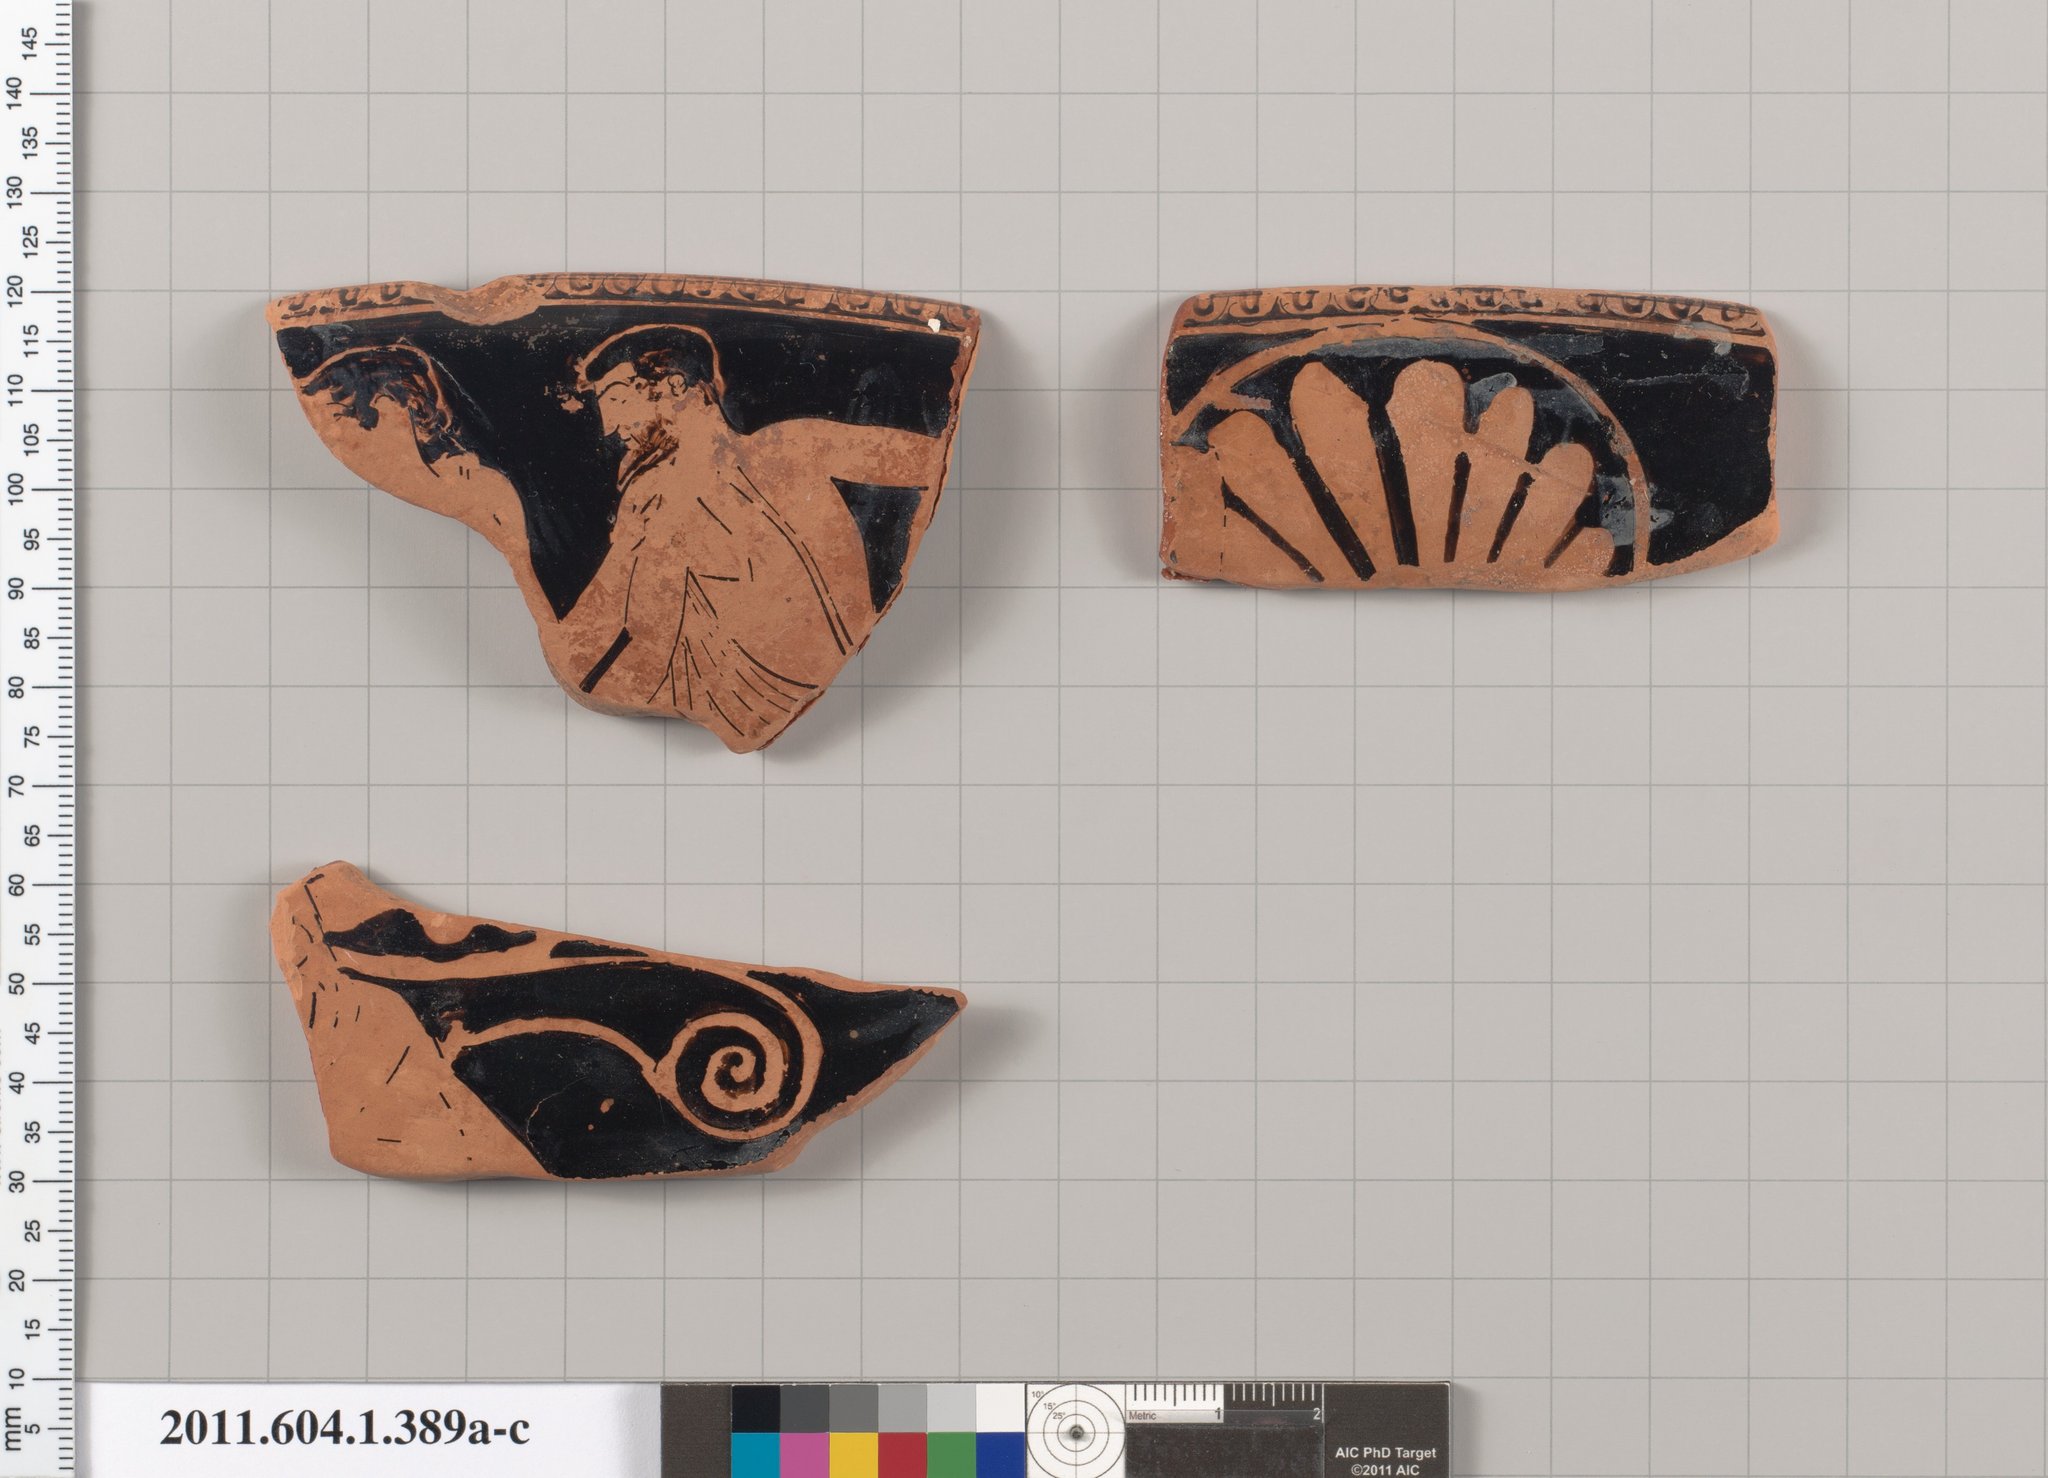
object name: kylix fragment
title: Terracotta rim fragments of a kylix (drinking cup)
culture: greek, attic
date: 460-450 BCE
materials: terracotta